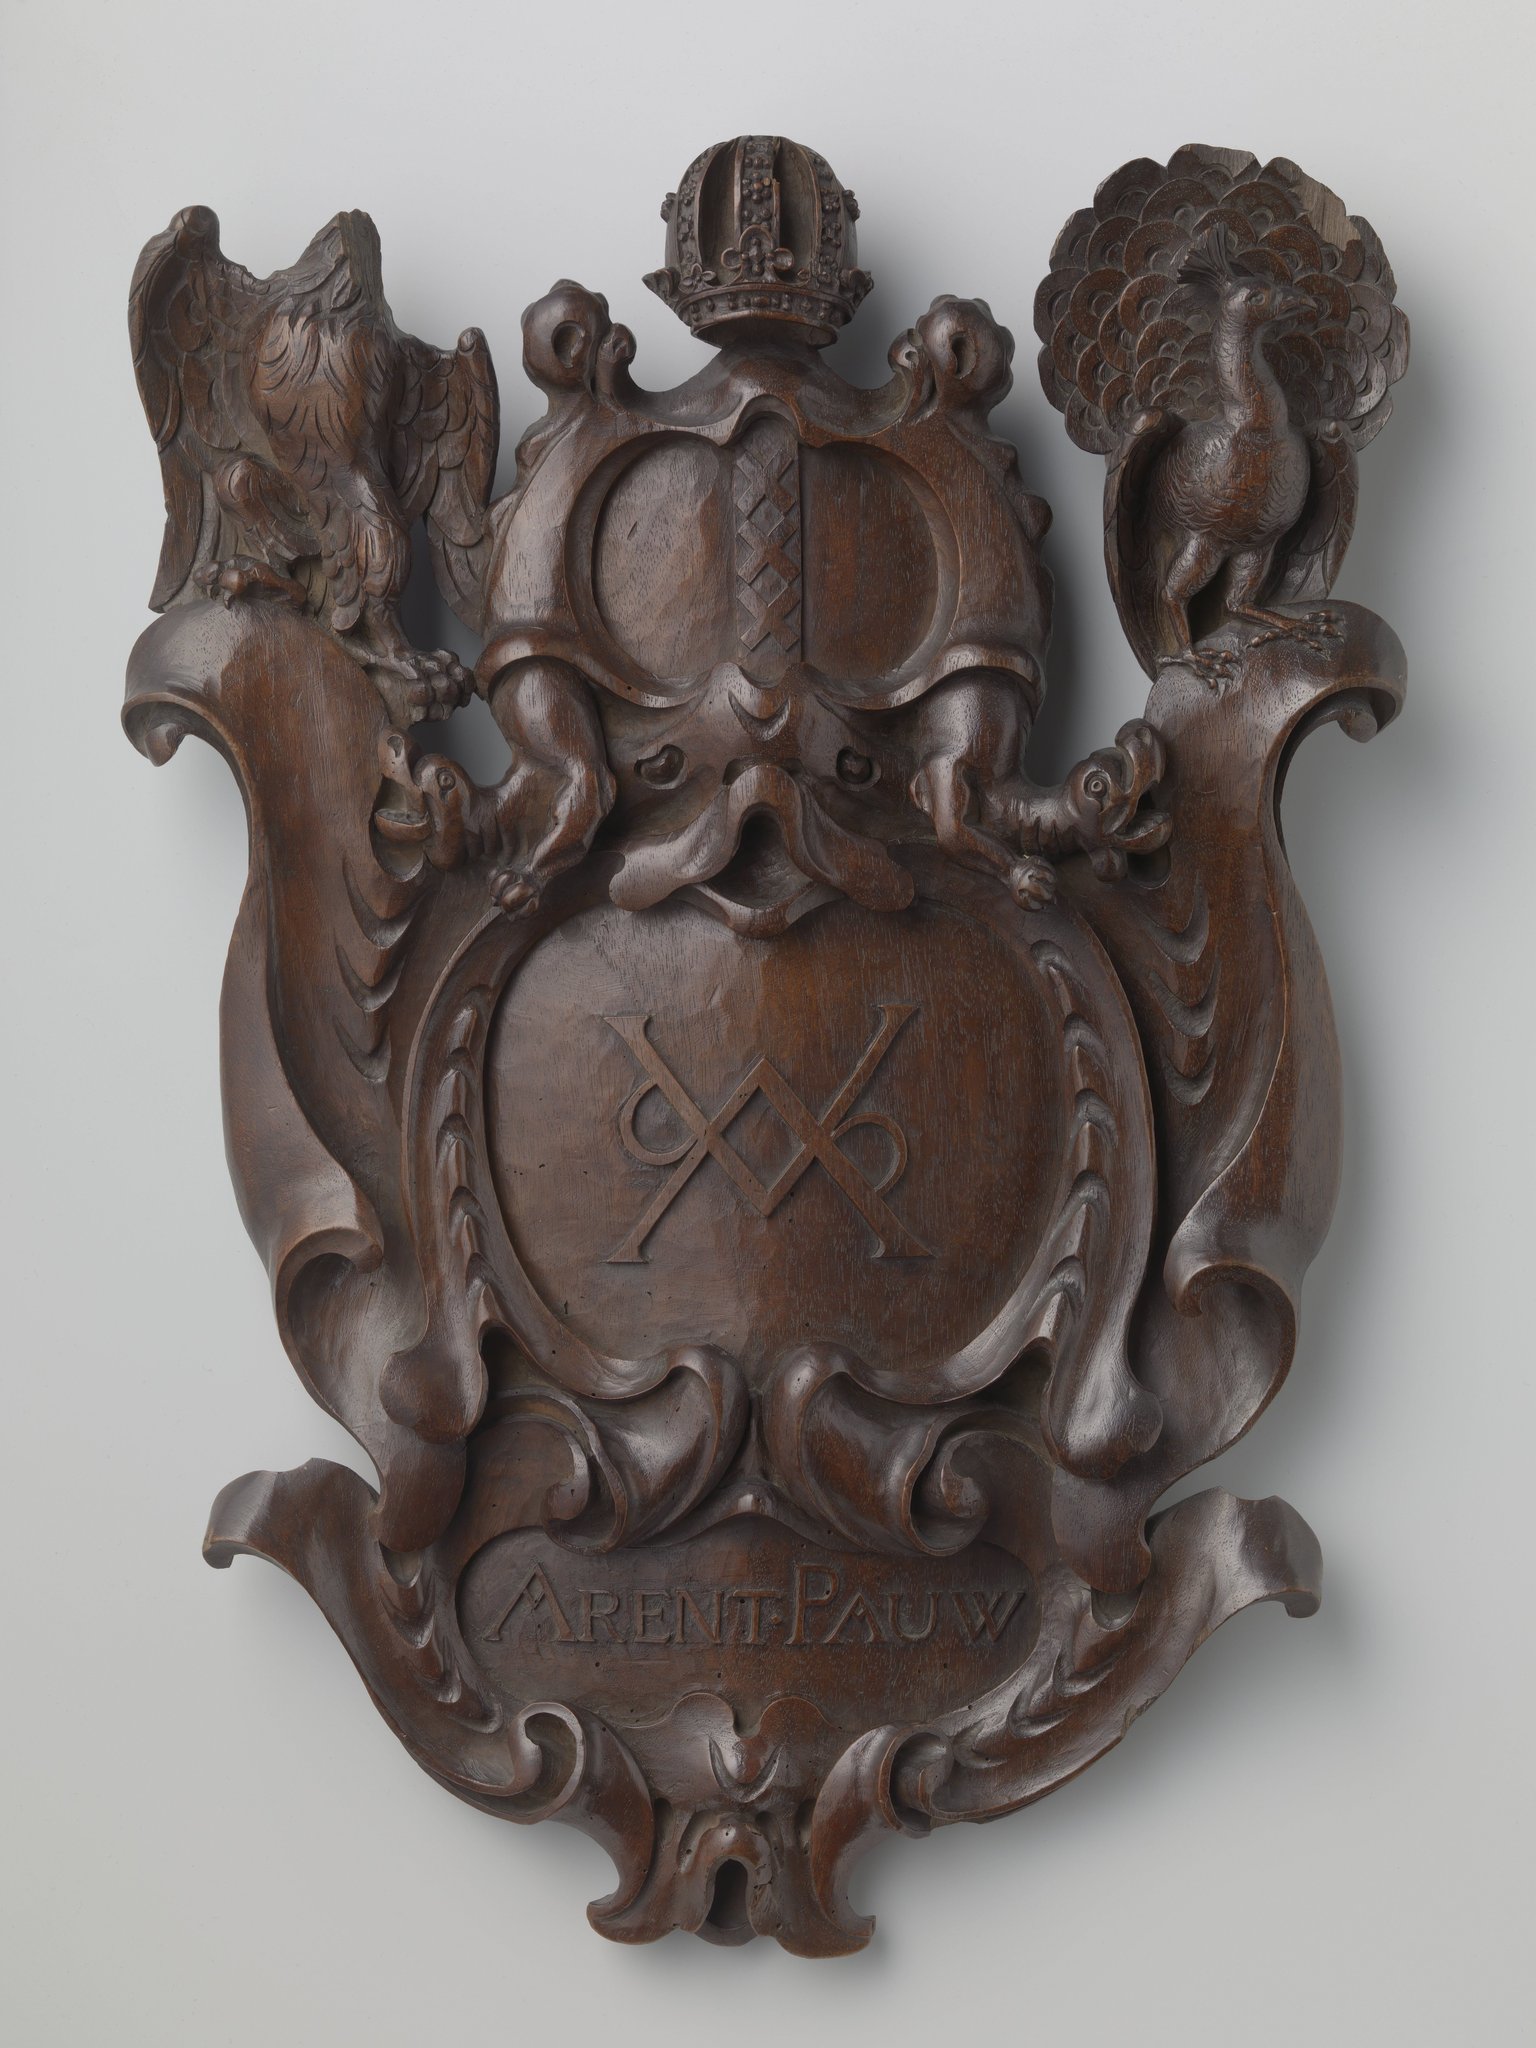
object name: interieuronderdeel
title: Wapenbord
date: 1700-1800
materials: paint, wood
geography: northern netherlands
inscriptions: monogram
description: Wapenbord van eikenhout met monogram van Arent Pauw. Drie Andreaskruisjen van Amsterdam, kroontje in het midden, arend en pauw boven op de hoeken.